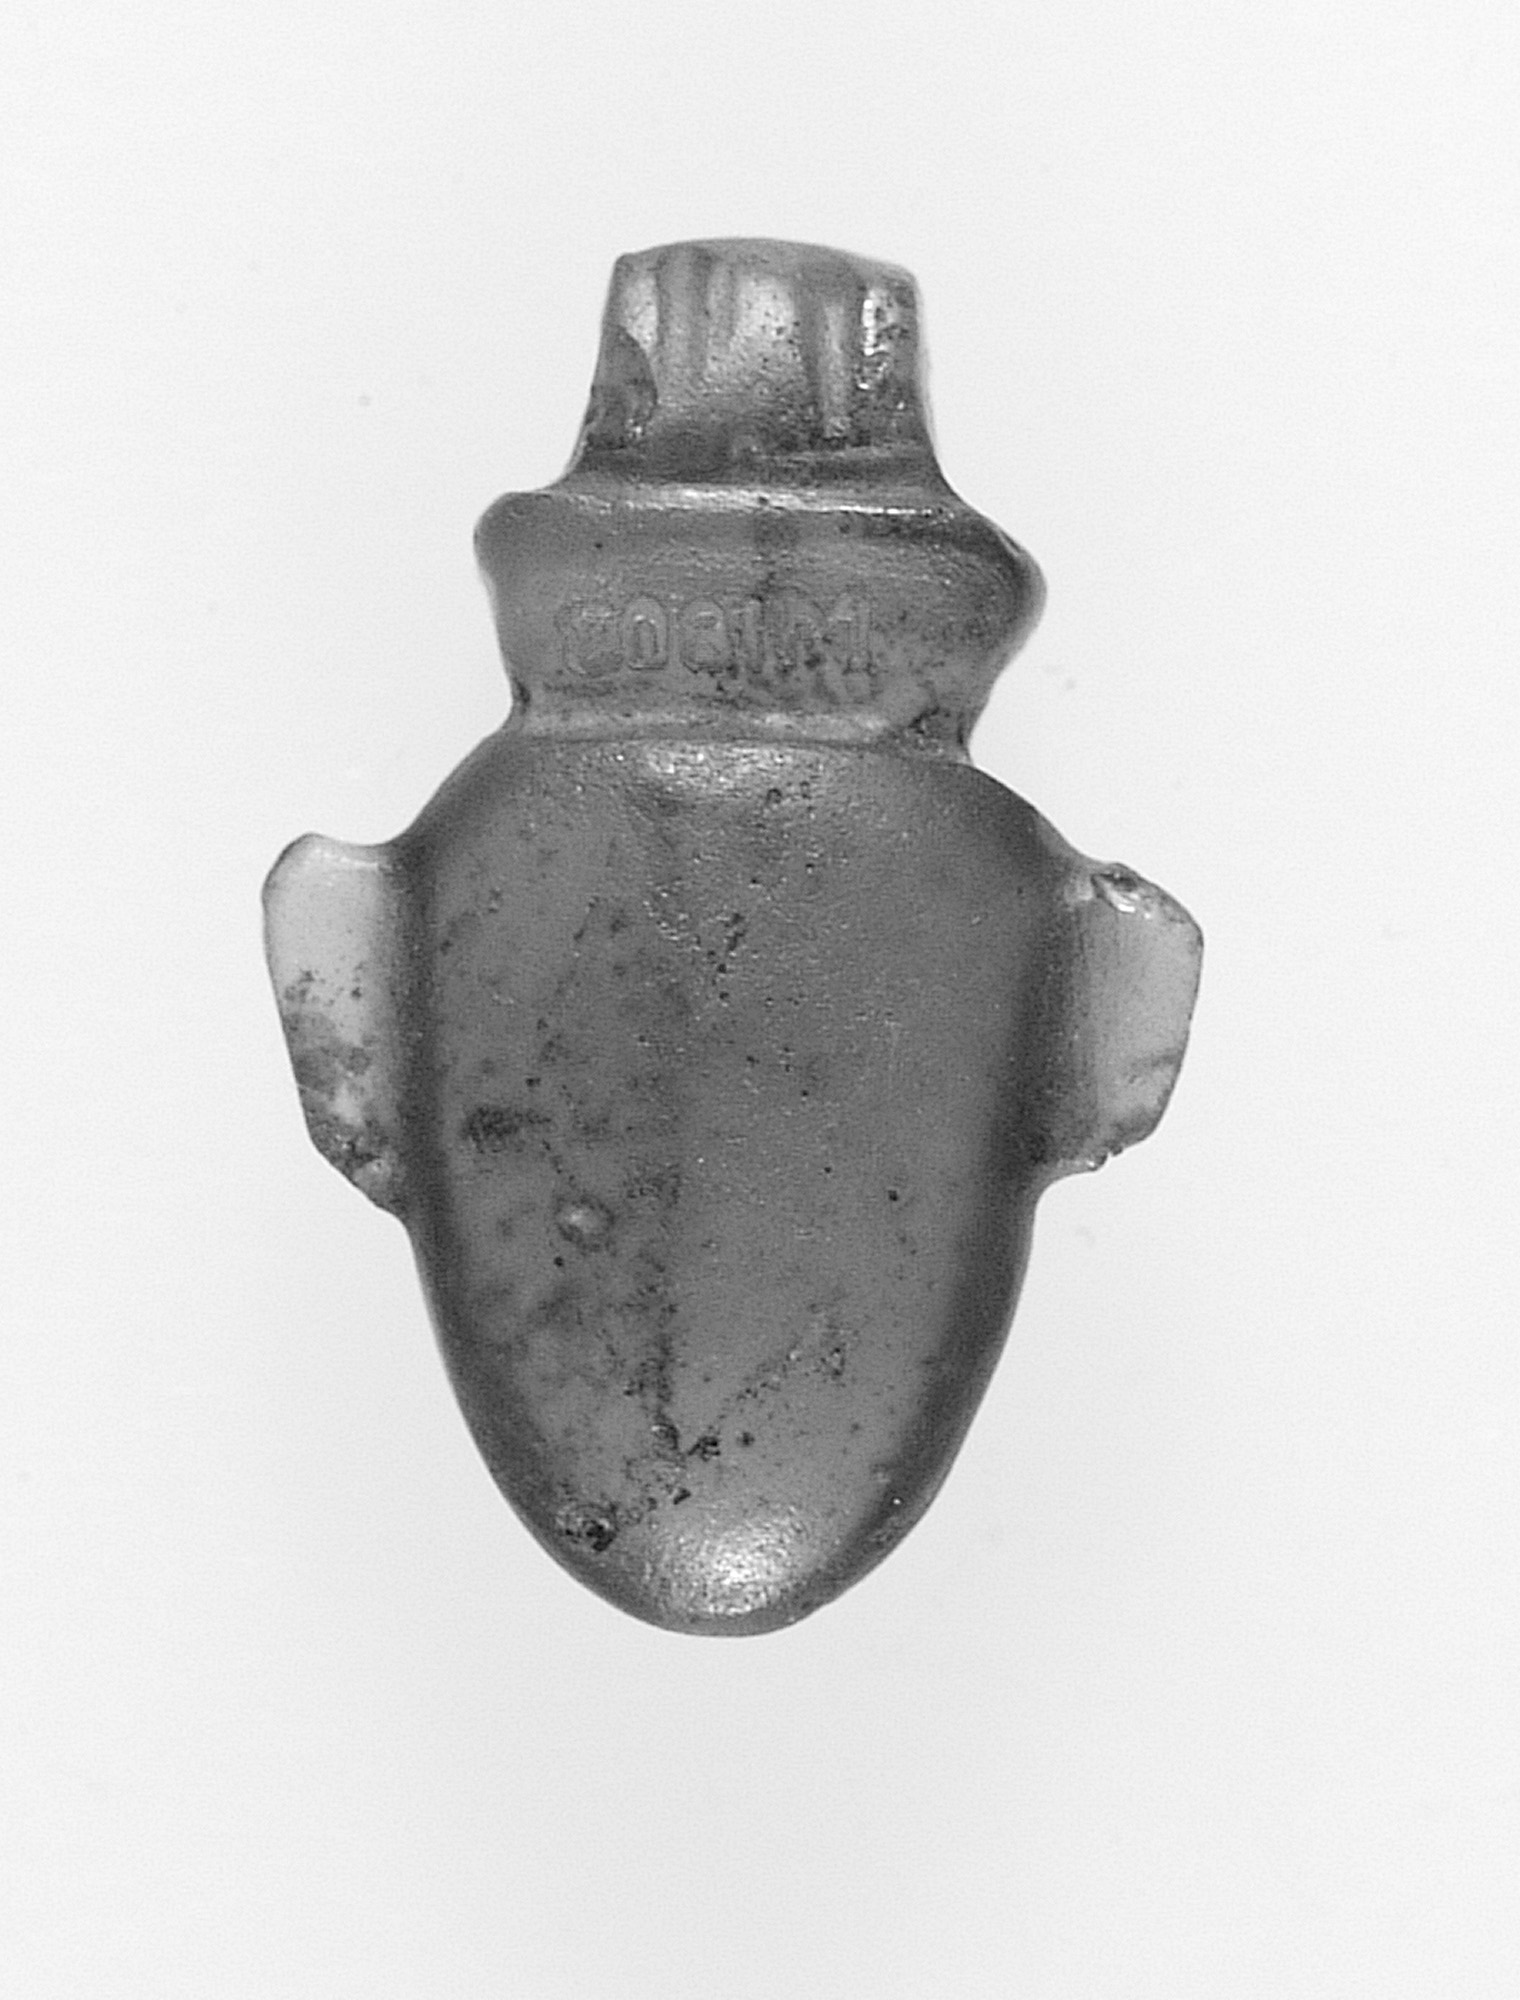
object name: amulet, heart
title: Heart amulet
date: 1070-664 BCE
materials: glass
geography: egypt